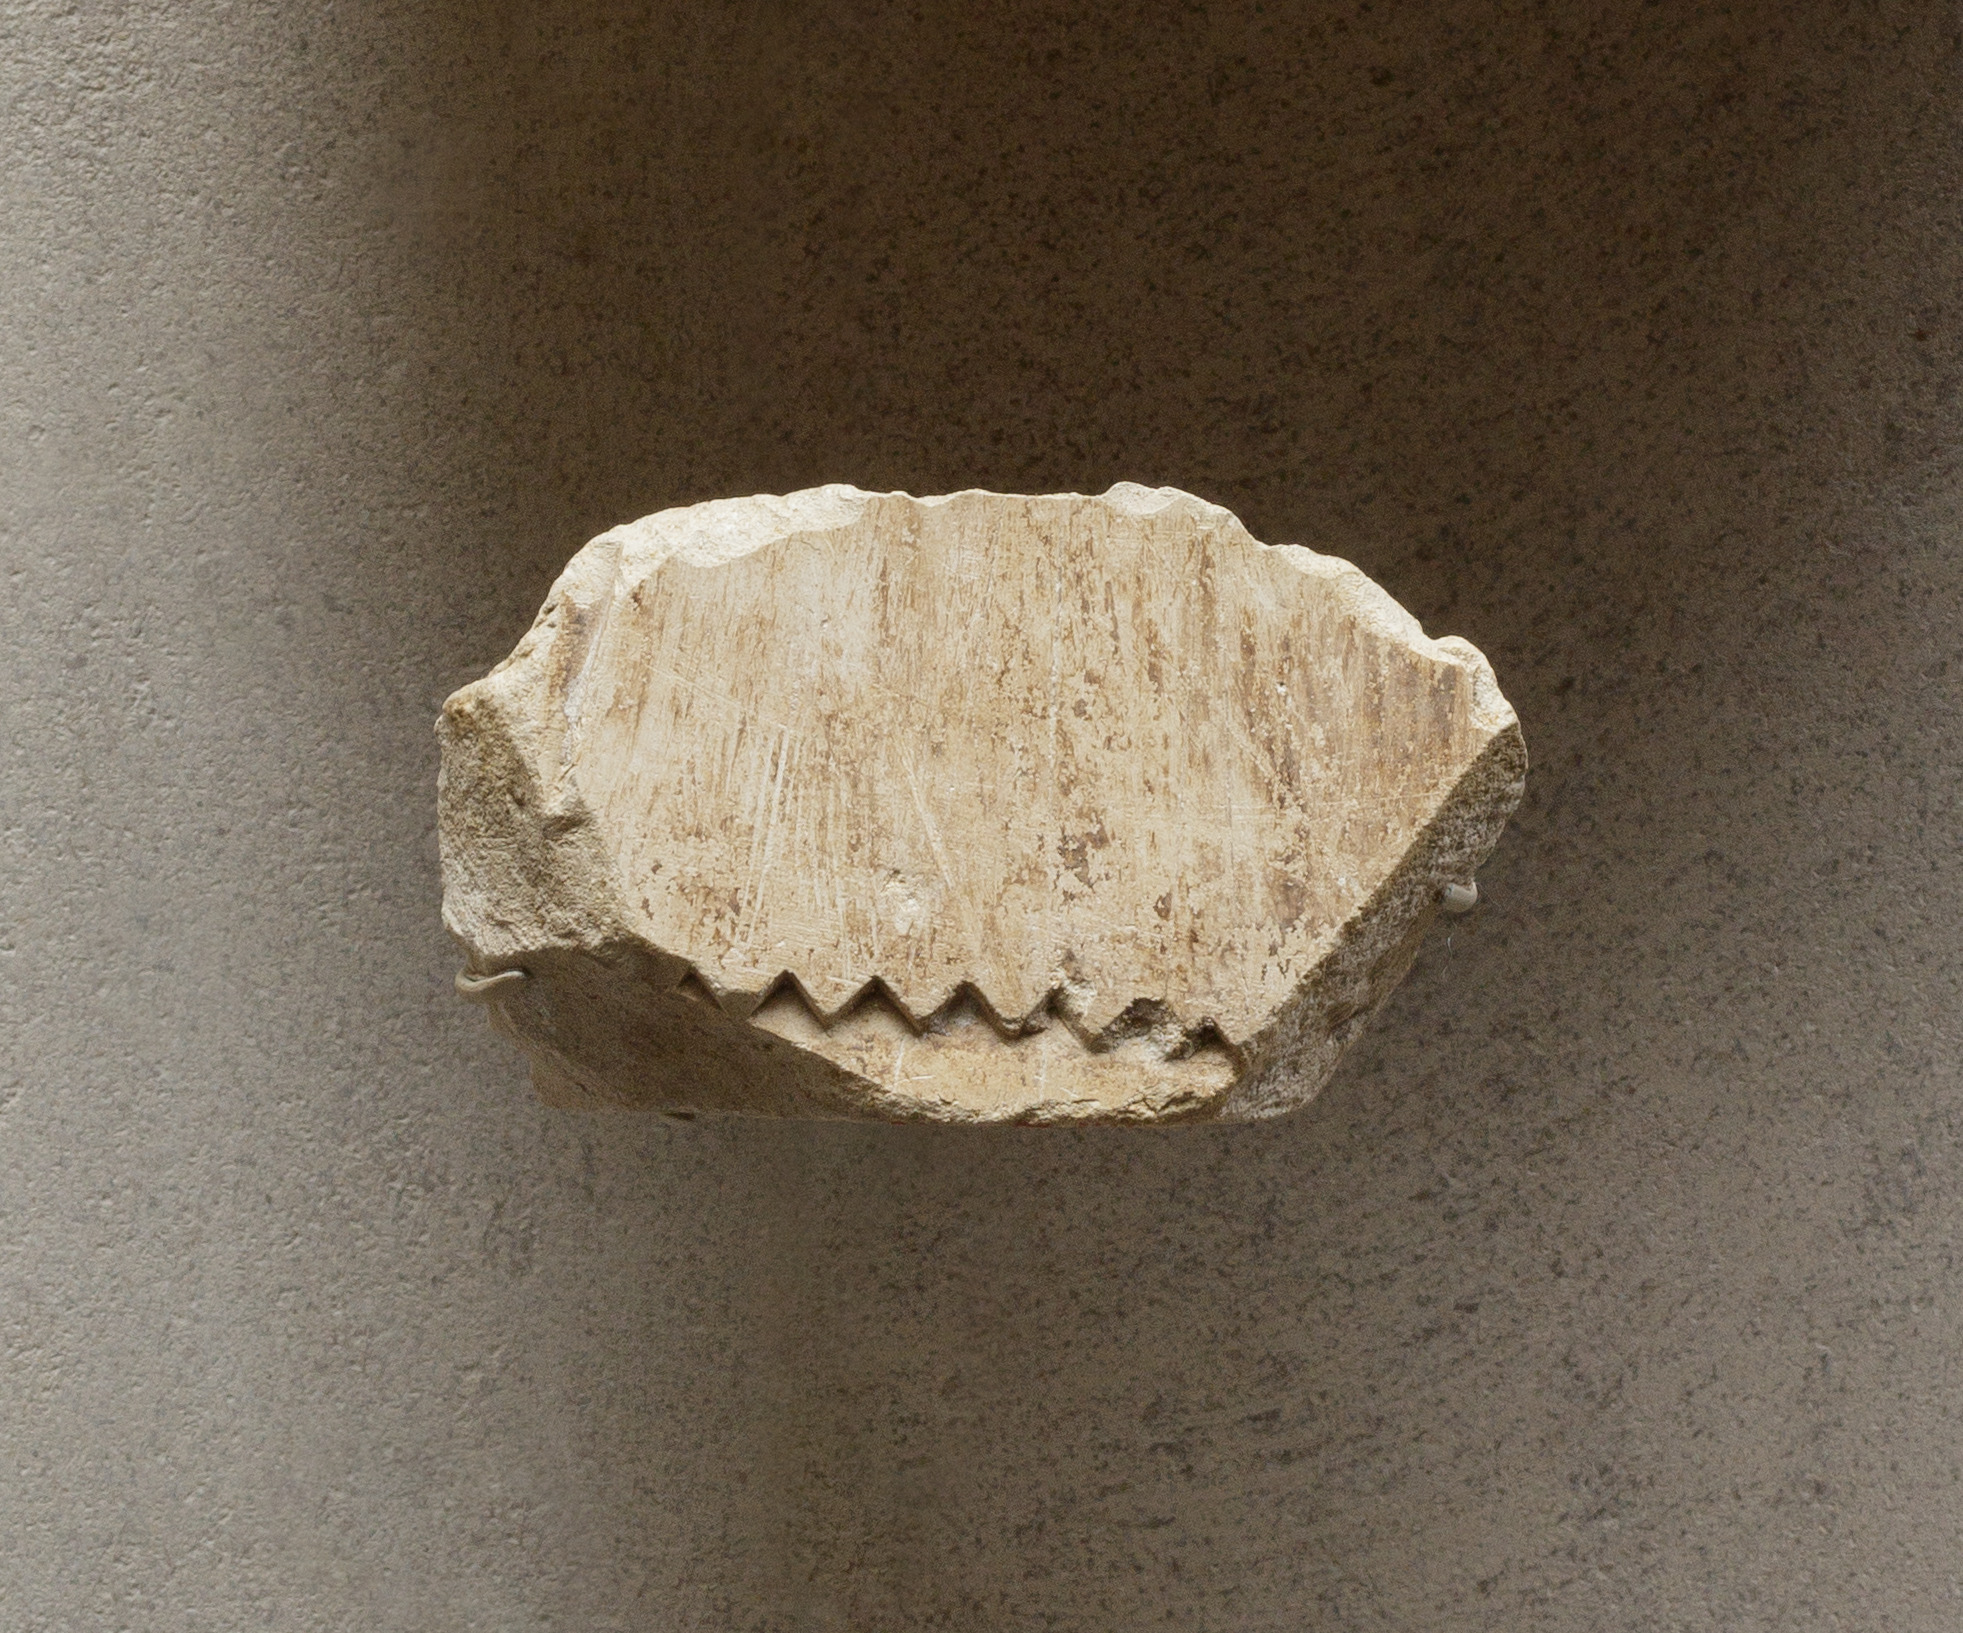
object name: relief fragment, tomb of neferu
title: Relief from the tomb of Queen Neferu: part of a sunshade (see 26.3.353-1)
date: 2051-2030 BCE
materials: limestone, paint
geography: egypt